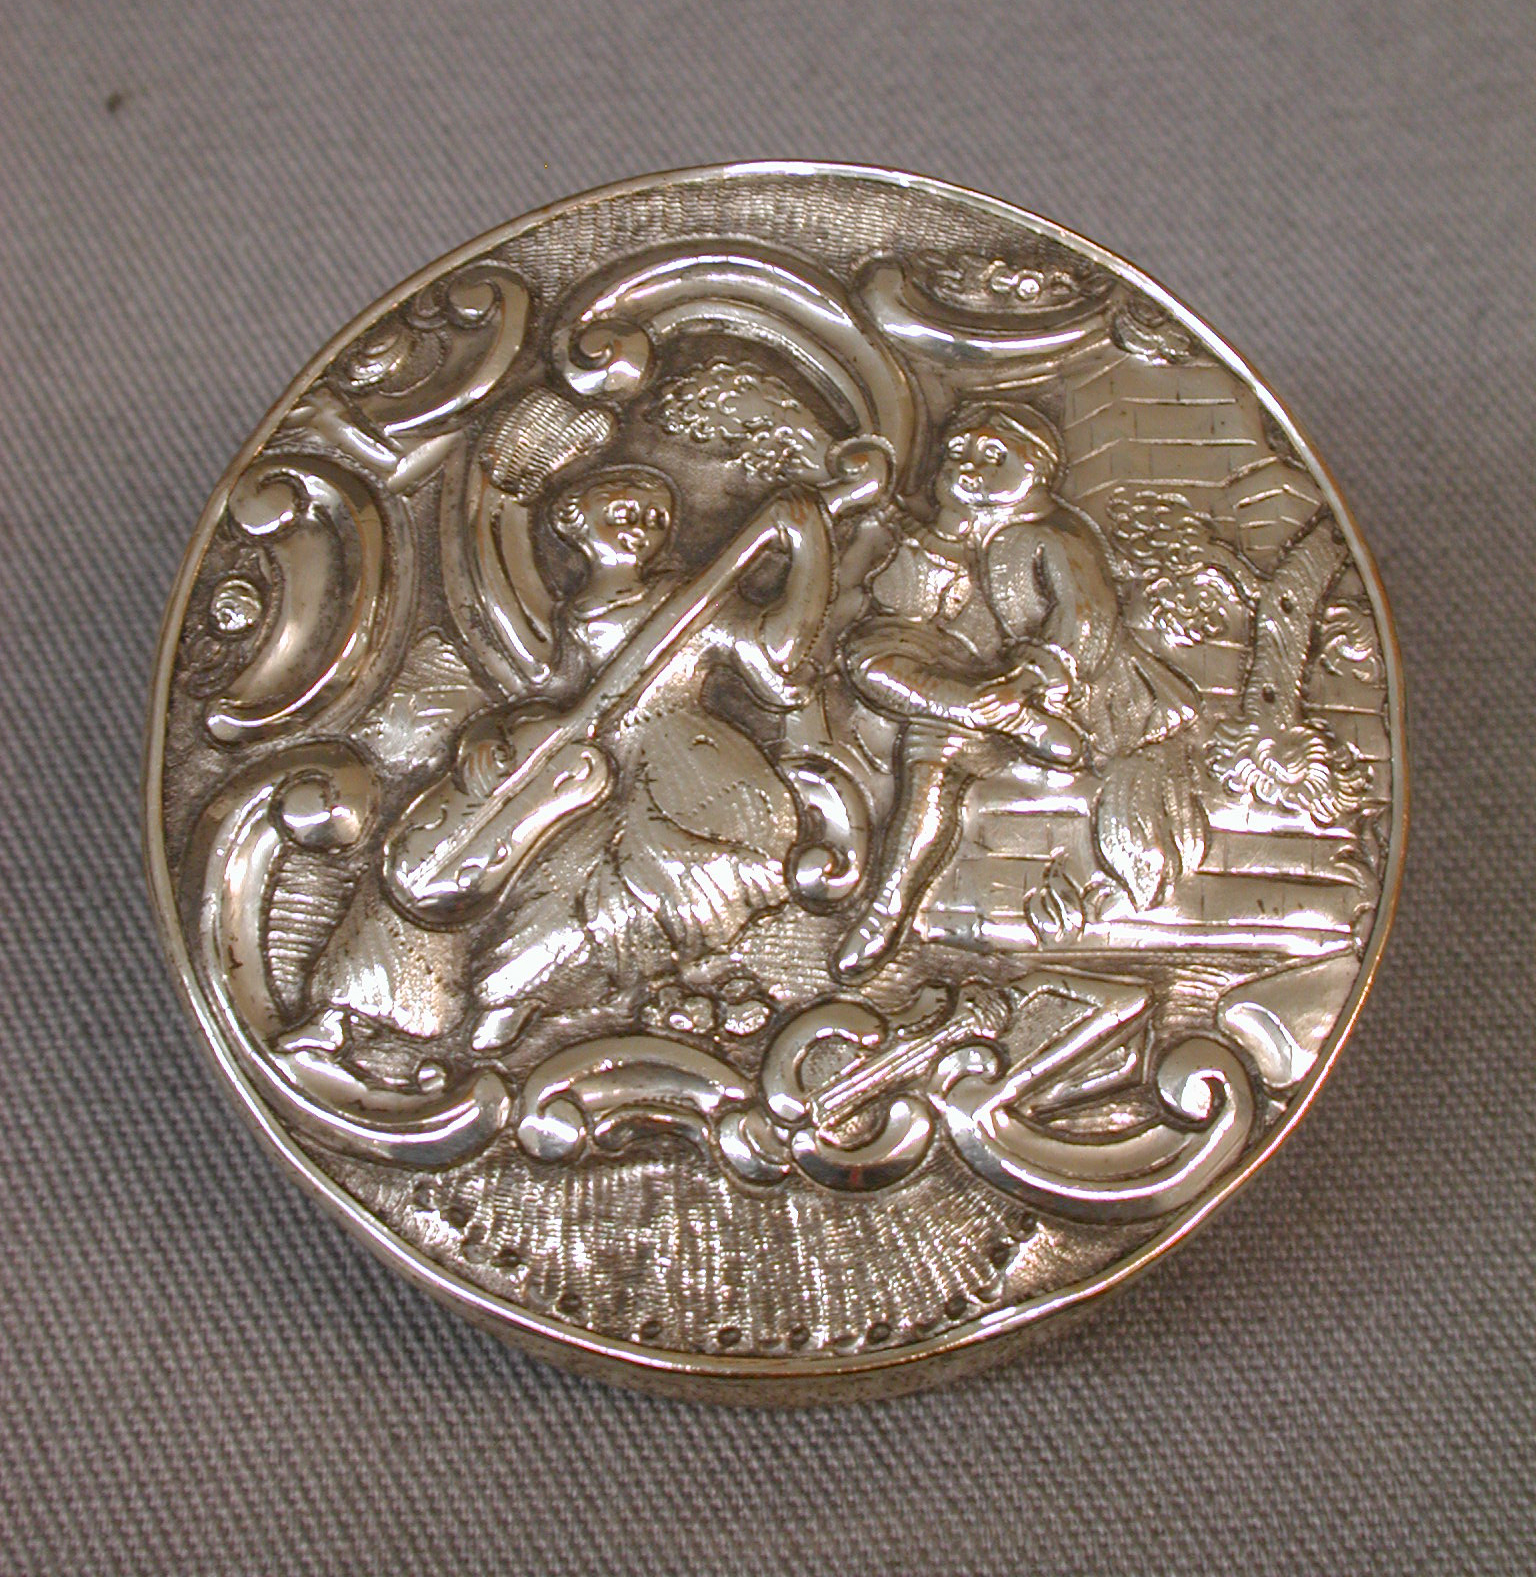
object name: snuffbox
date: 1750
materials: metal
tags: musical instruments,men,women